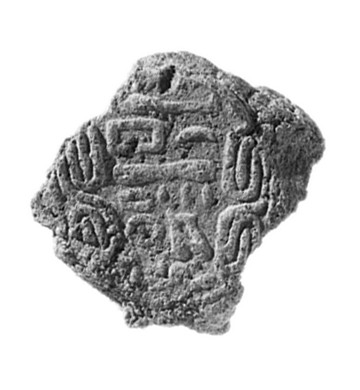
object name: sealing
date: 1981-1640 BCE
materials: mud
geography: egypt